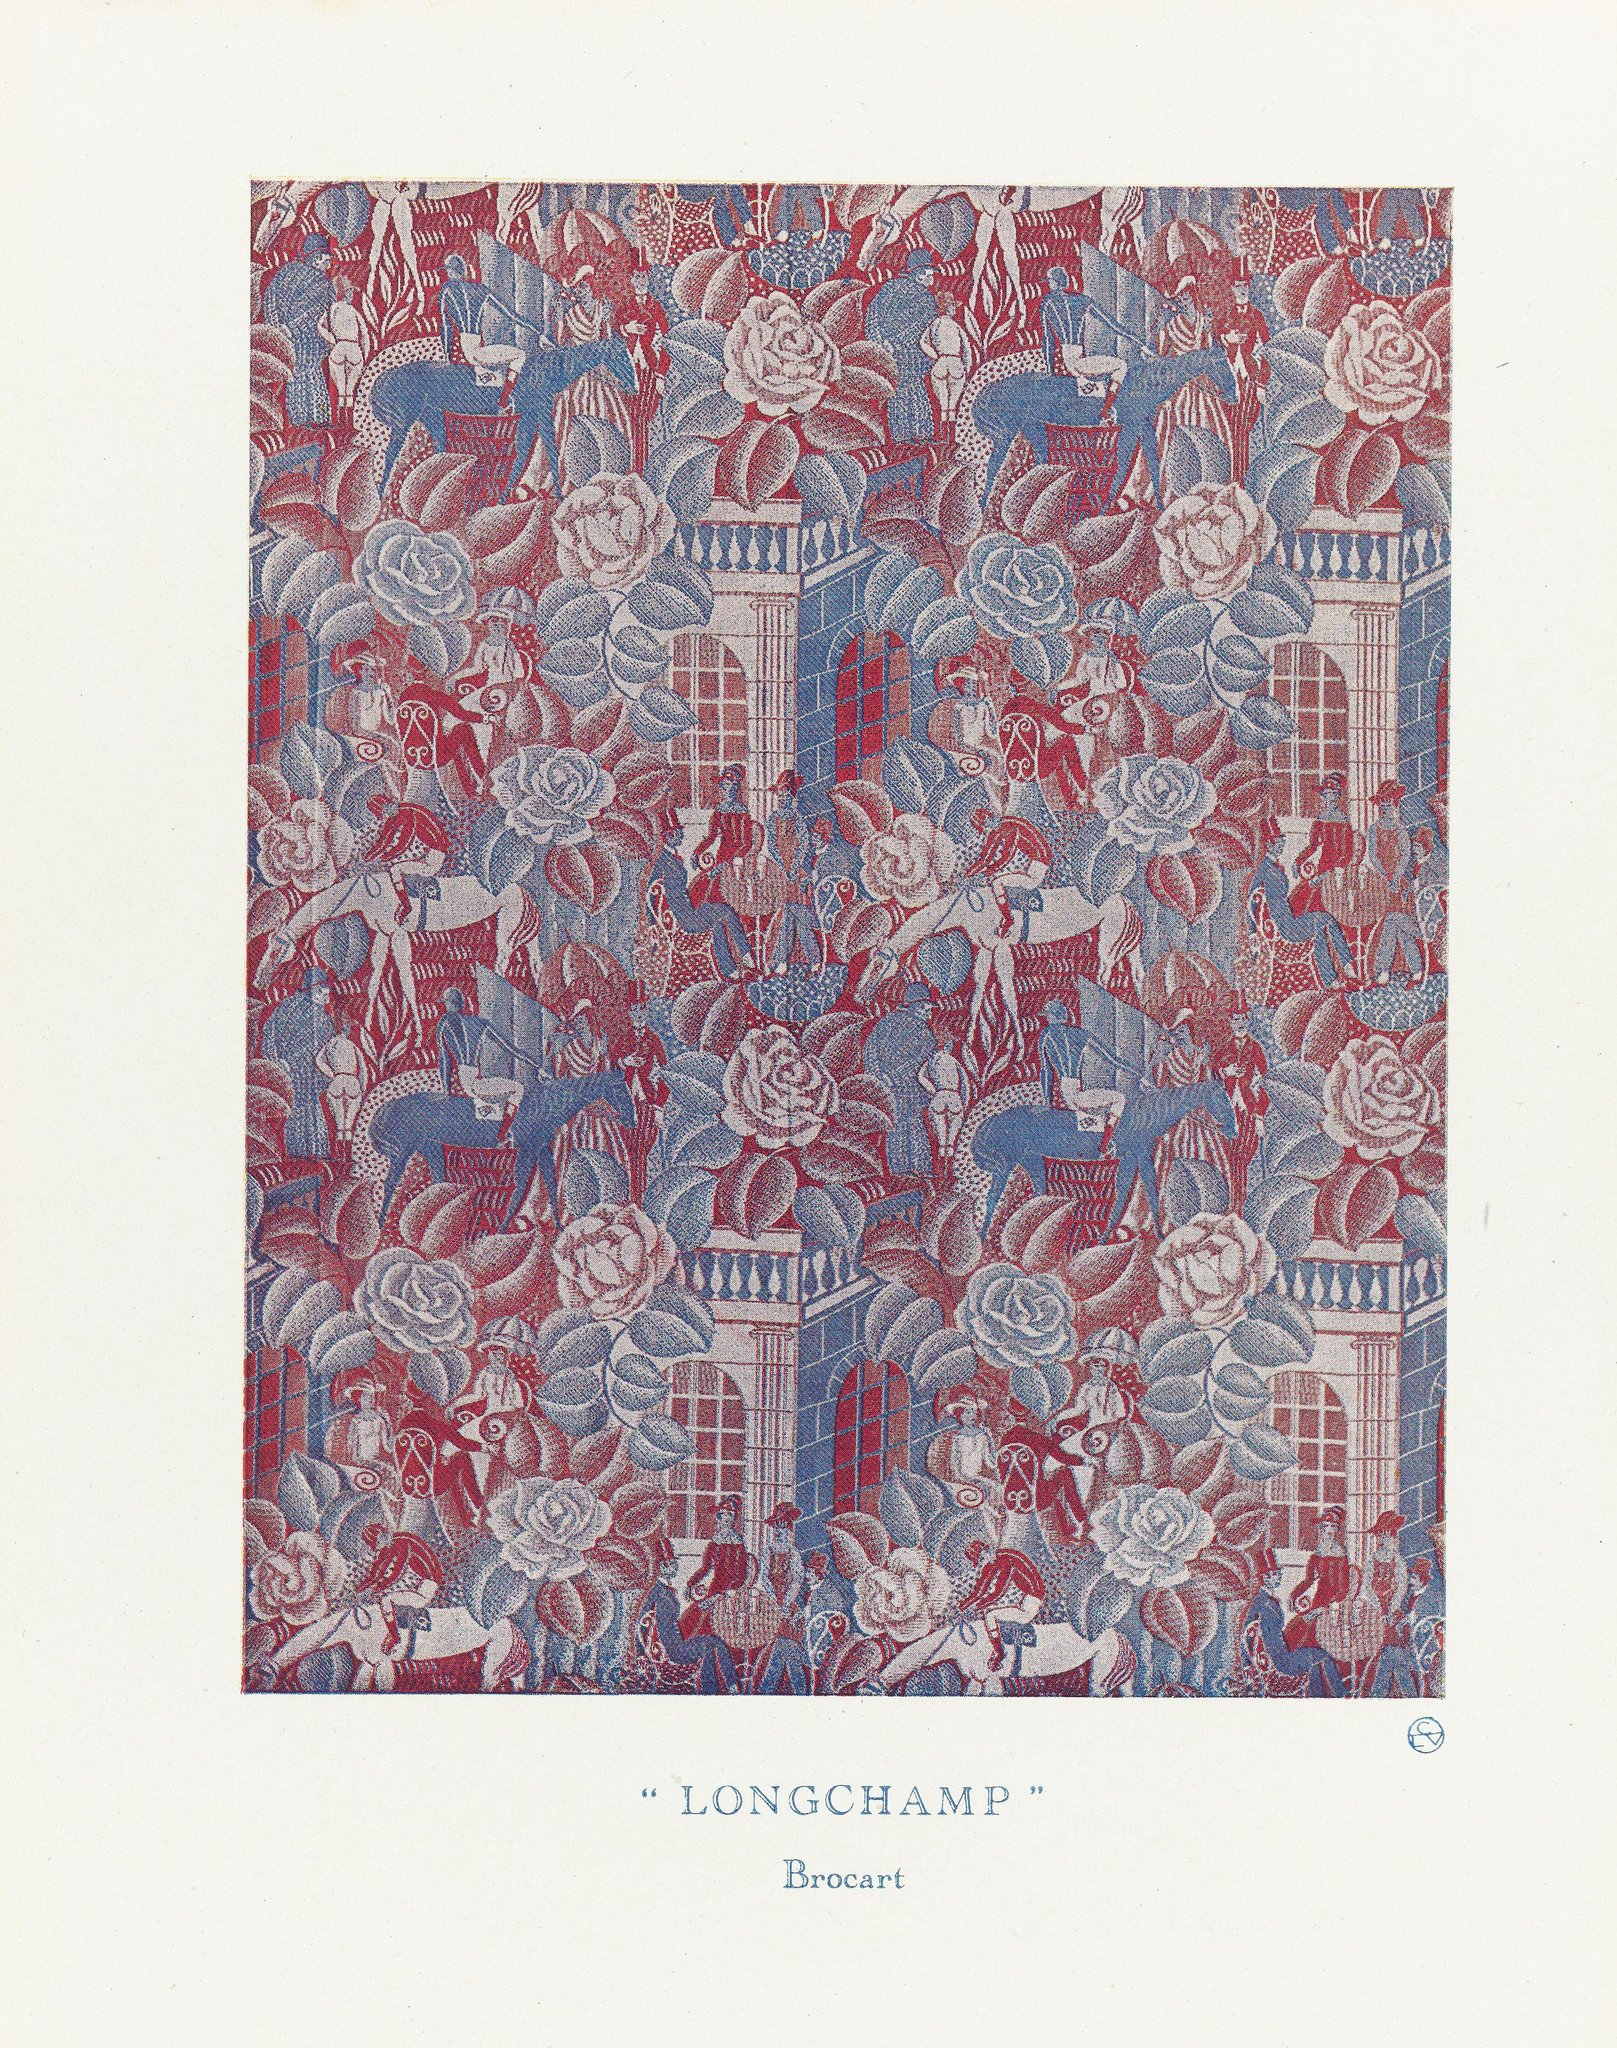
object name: fashion print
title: Gazette du Bon Ton, 1920 - No. 8, Pl. XXXVII: "Longchamp" / Brocart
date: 1920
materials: paper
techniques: printing, letterpress printing, photochemical processes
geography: geneva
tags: textile fabric, cloth (+ plan, design ~ production), fashion plates, horse-racing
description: Stofpatroon met bloemen en scénes van paarden en jockeys bij Longchamp. De stof is ontworpen door Raoul Dufy. en gemaakt door de bekende zijdefabrikant Bianchini Férier, bij wie Dufy tussen 1912 en 1928 als ontwerper in dienst was. Mede door deze samenwerking werd hij een van de belangrijkste stofontwerpers van de 20ste eeuw. De prent maakt deel uit een serie van vier ontwerpen voor meubelstoffen, getiteld: 'Toiles de tournon lampas, brocarts et brocatelles.' Planche XXXVII uit Gazette du Bon Ton 1920, No. 8. Uitleg over de stoffen op pagina "Explication des Planches".